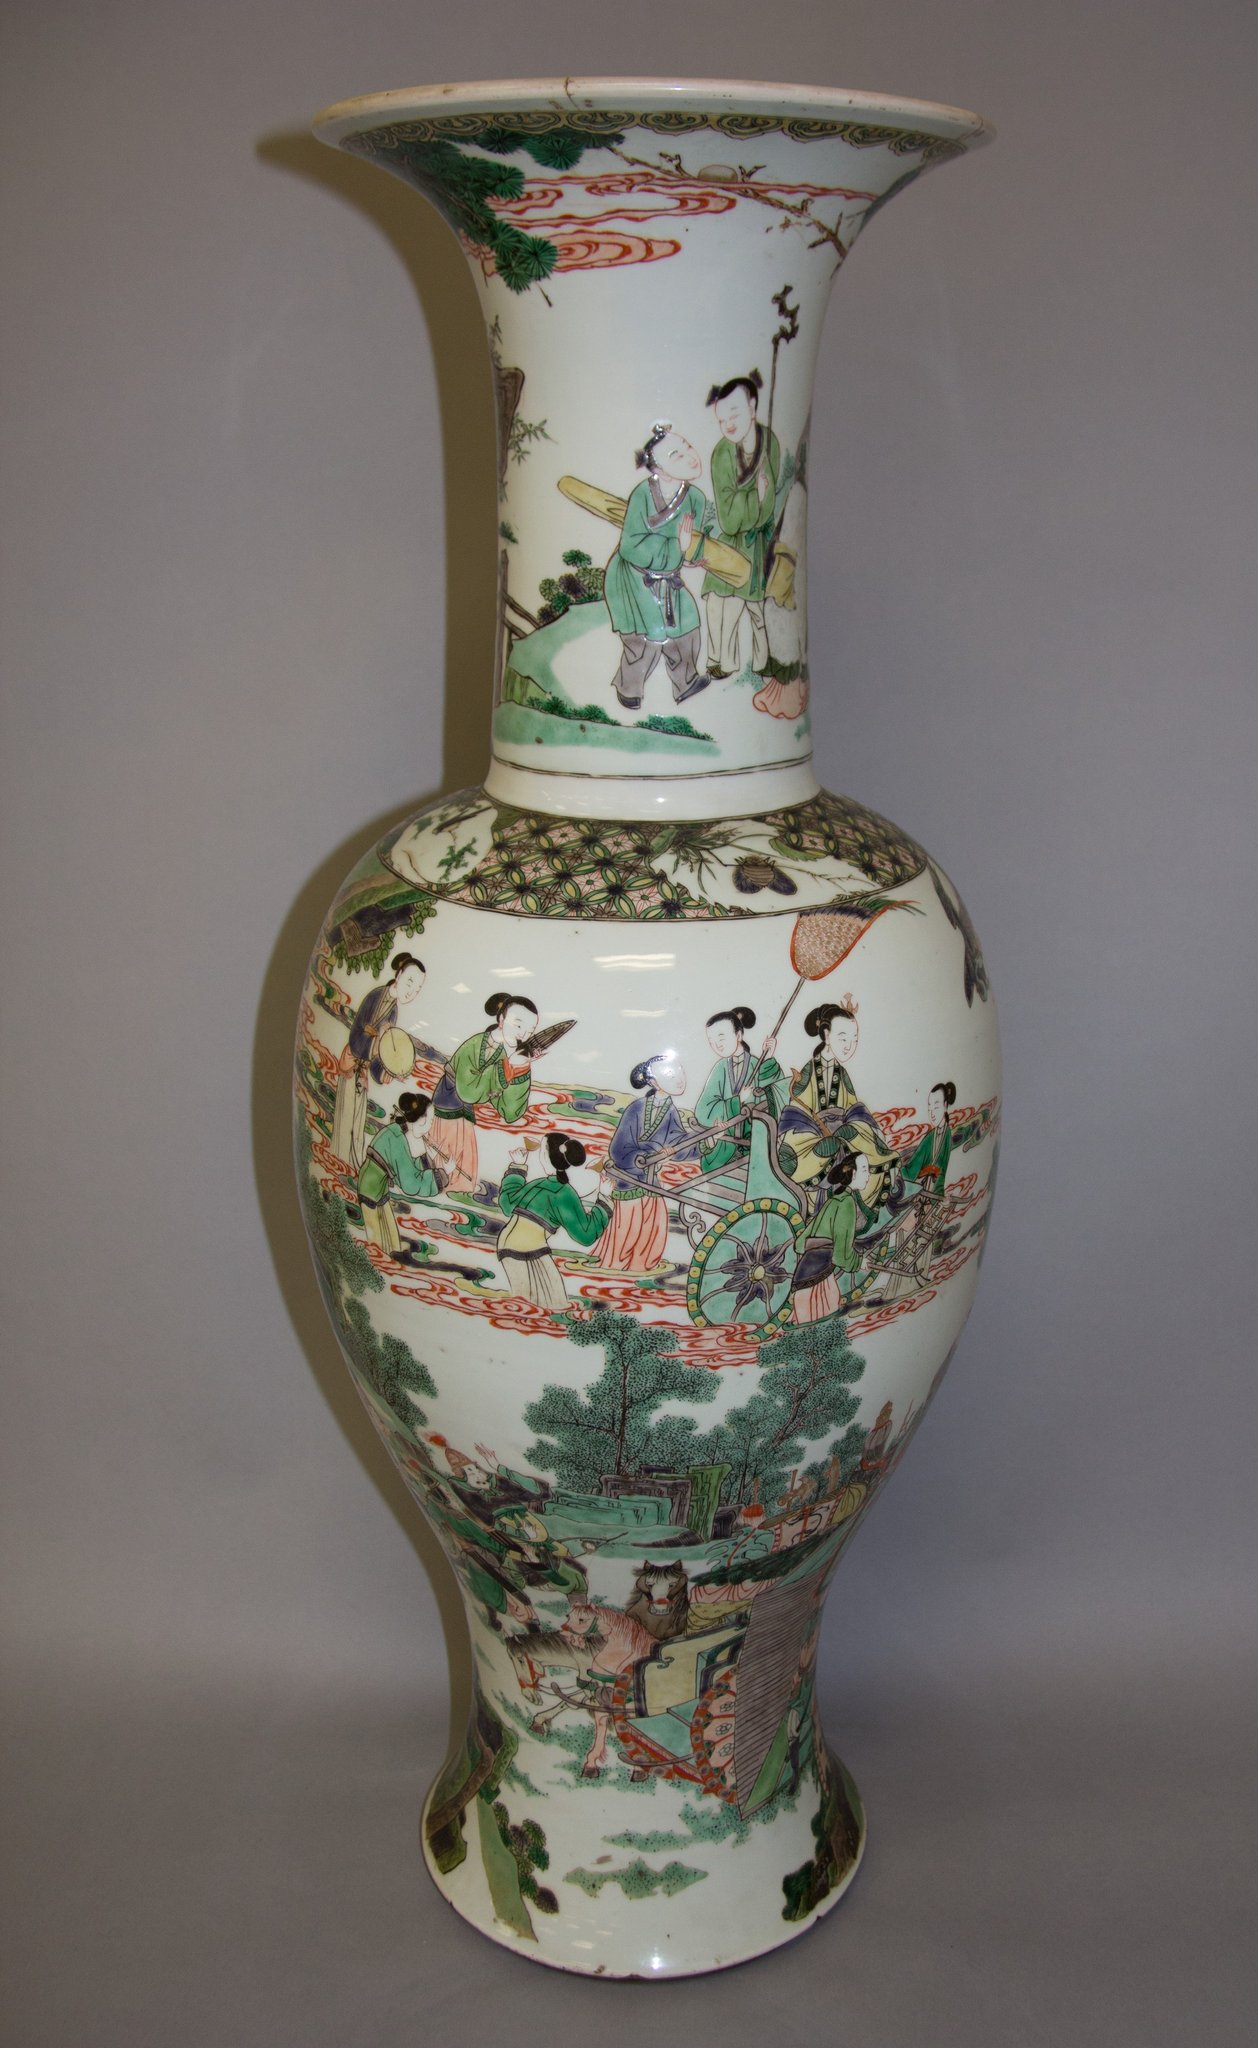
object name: vase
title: Vase with immortals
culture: chinese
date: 1667-1733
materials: enamel, porcelain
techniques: overglaze, painting, polychrome